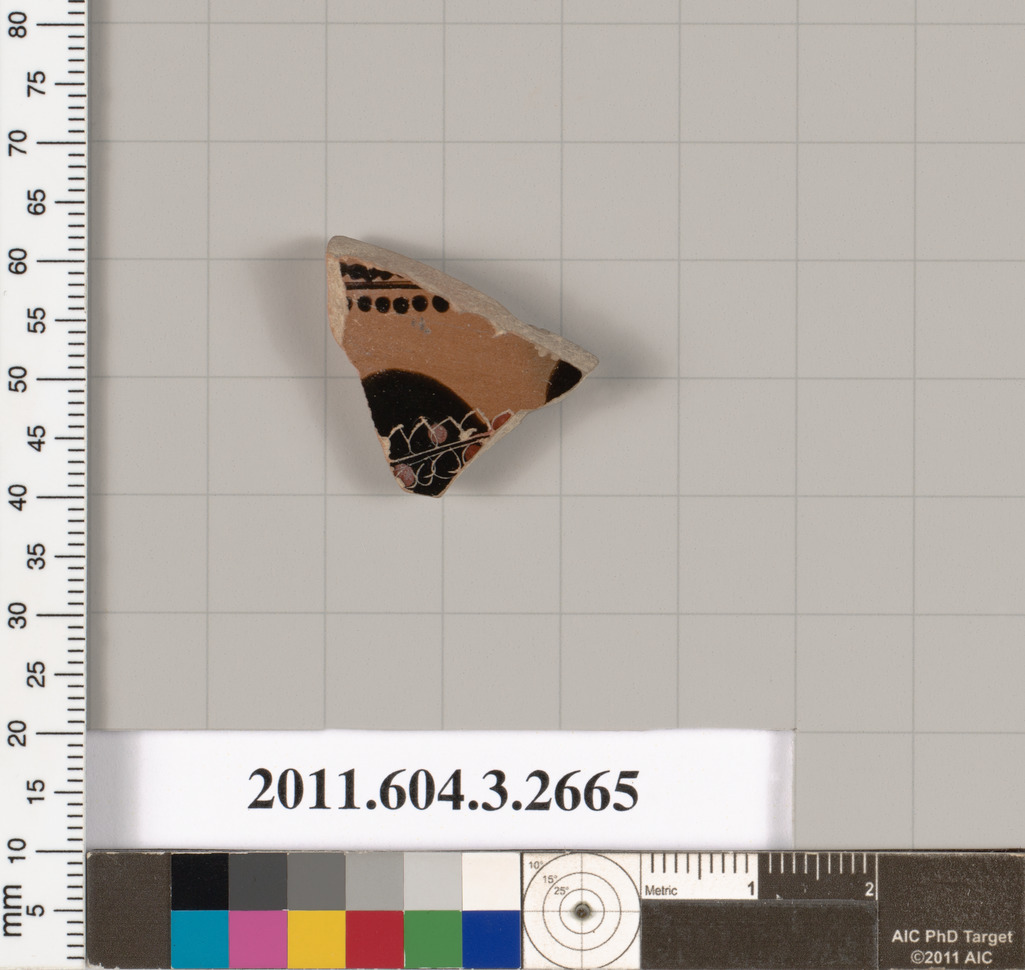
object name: olpe fragment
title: Terracotta fragment of an olpe (jug)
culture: greek, attic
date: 530-510 BCE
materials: terracotta